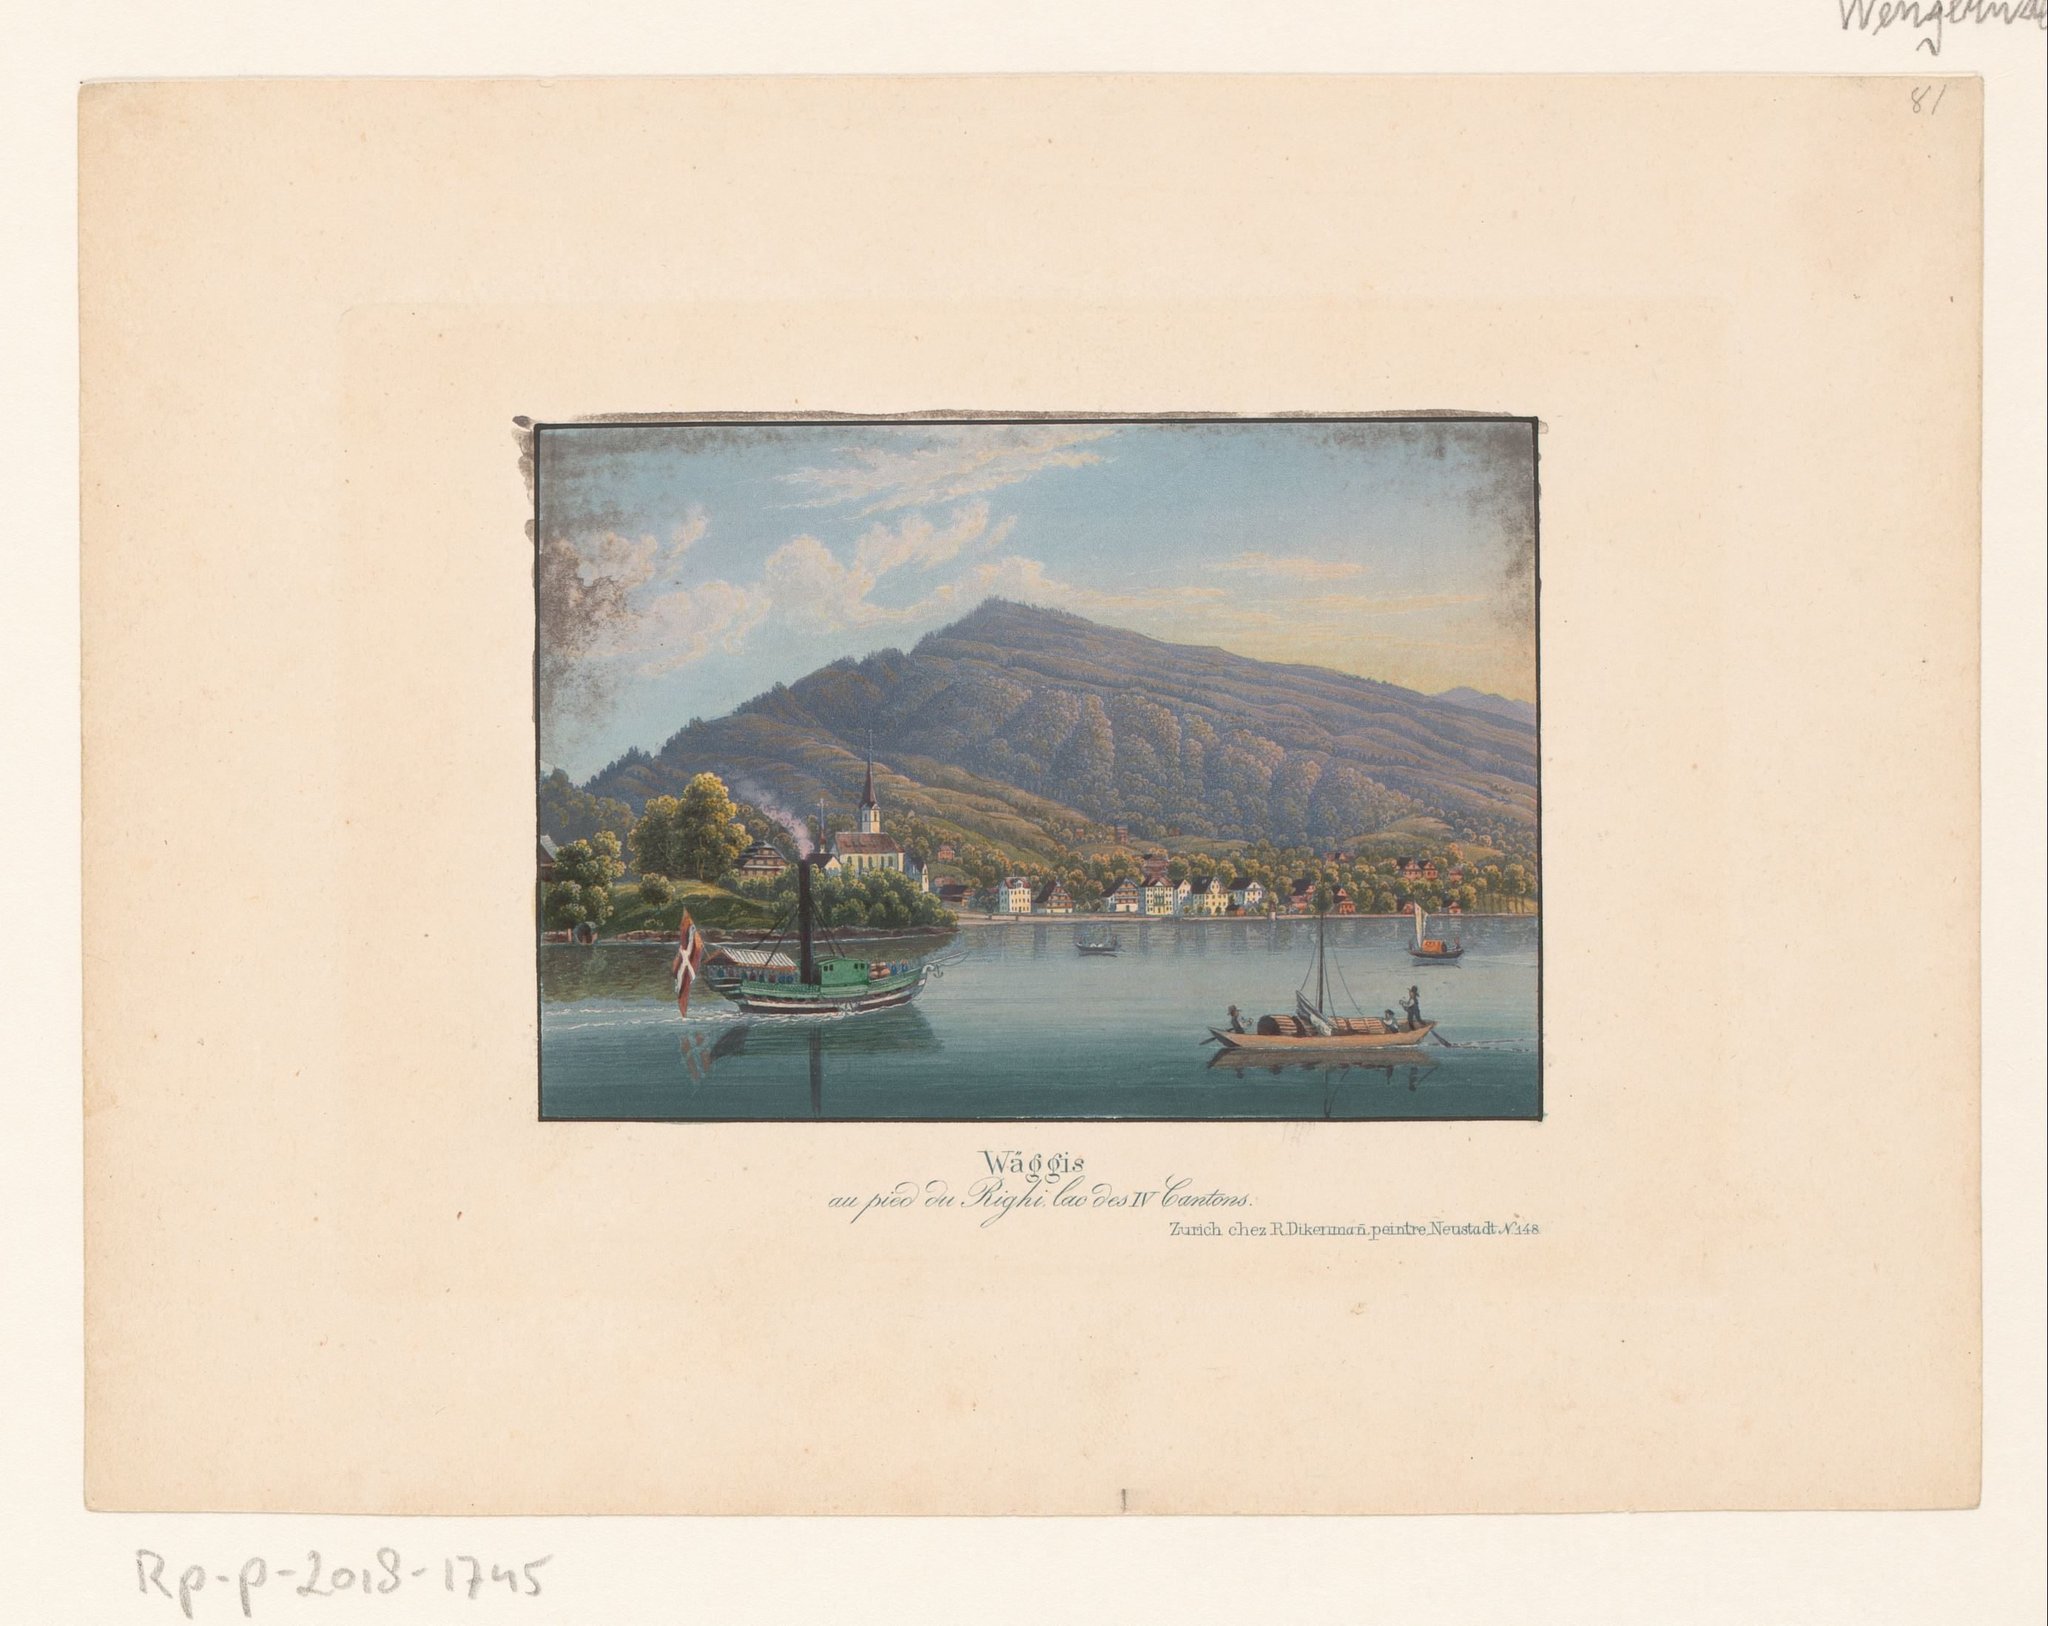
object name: print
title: Wäggis au pied du Righi, lac des IV cantons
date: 1800-1899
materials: paper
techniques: aquatint, hand coloring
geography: zurich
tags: prospect of village, silhouette of village, lake, mountains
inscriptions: collector's mark: Lugt 2228